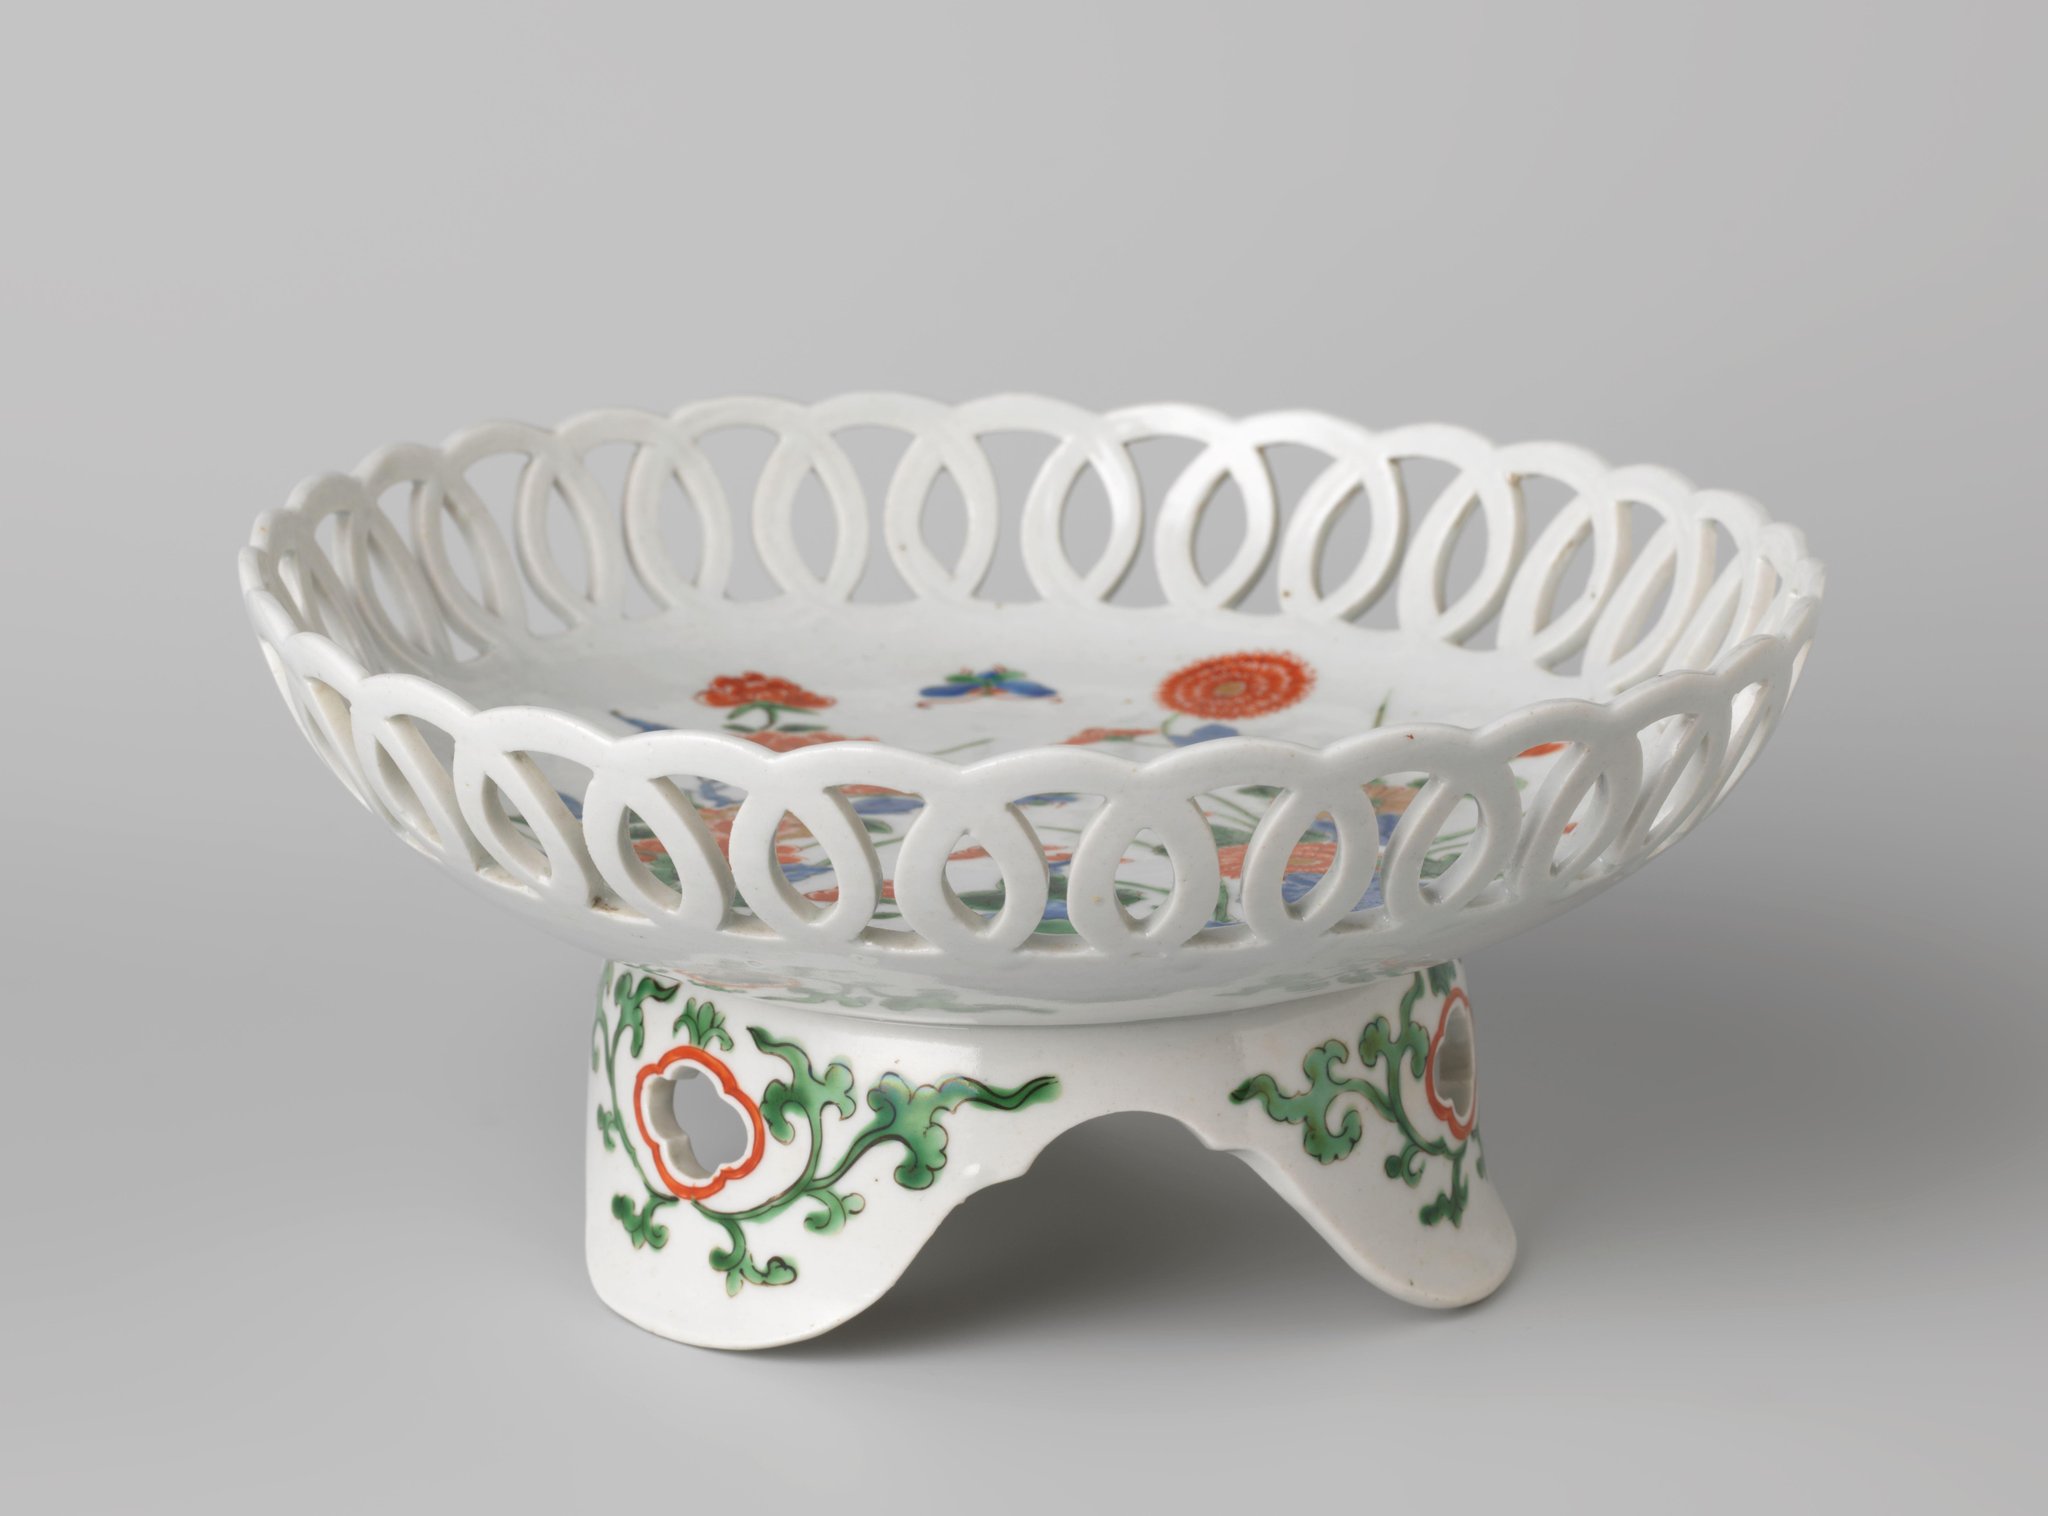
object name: dish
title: Saucer-dish on tripod with flowering plants near rocks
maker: Anonymous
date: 1700-1724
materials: glaze, gold, porcelain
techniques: embroidery, firing, gilding, turning, vitrification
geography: japan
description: AK-NM-6377 Twee schalen op voet • Japans gekleurd porselein – Arita • Onderdeel van Royers porseleincollectie • Mogelijk afkomstig van Susanna Louise Huygens Maar liefst acht Japanse gekleurde fruitschalen met opengewerkte rand worden genoemd in de boedel van Royers oudtante, Susanna Louoise Huygens (1714-1785). Royer kocht veel porselein uit haar nalatenschap en mogelijk ook twee van deze schalen – al rept de boedel van Susanna Louise niet van een voet: ‘Twee fruitschaalen met doorgeslaage randen’ en ‘ses Japansche fruitschaalen met doorgebrooke randen.’ Deze schalen komen vrij geregeld voor, ook in oude collecties zoals die van Burghley House en Kassel [Lang 1983, nrs 74 en 75; Porzellan aus China und Japan 1990, nr. 305]. Bronnen: Gordon Lang, The wrestling boys: an exhibition of Chinese and Japanese ceramics from the 16th to the 18th century in the collection at Burghley House, N.pl., 1983. Porzellan aus China und Japan: die Porzellangalerie der Landgrafen von Hessen-Kassel, Berlijn, 1990.